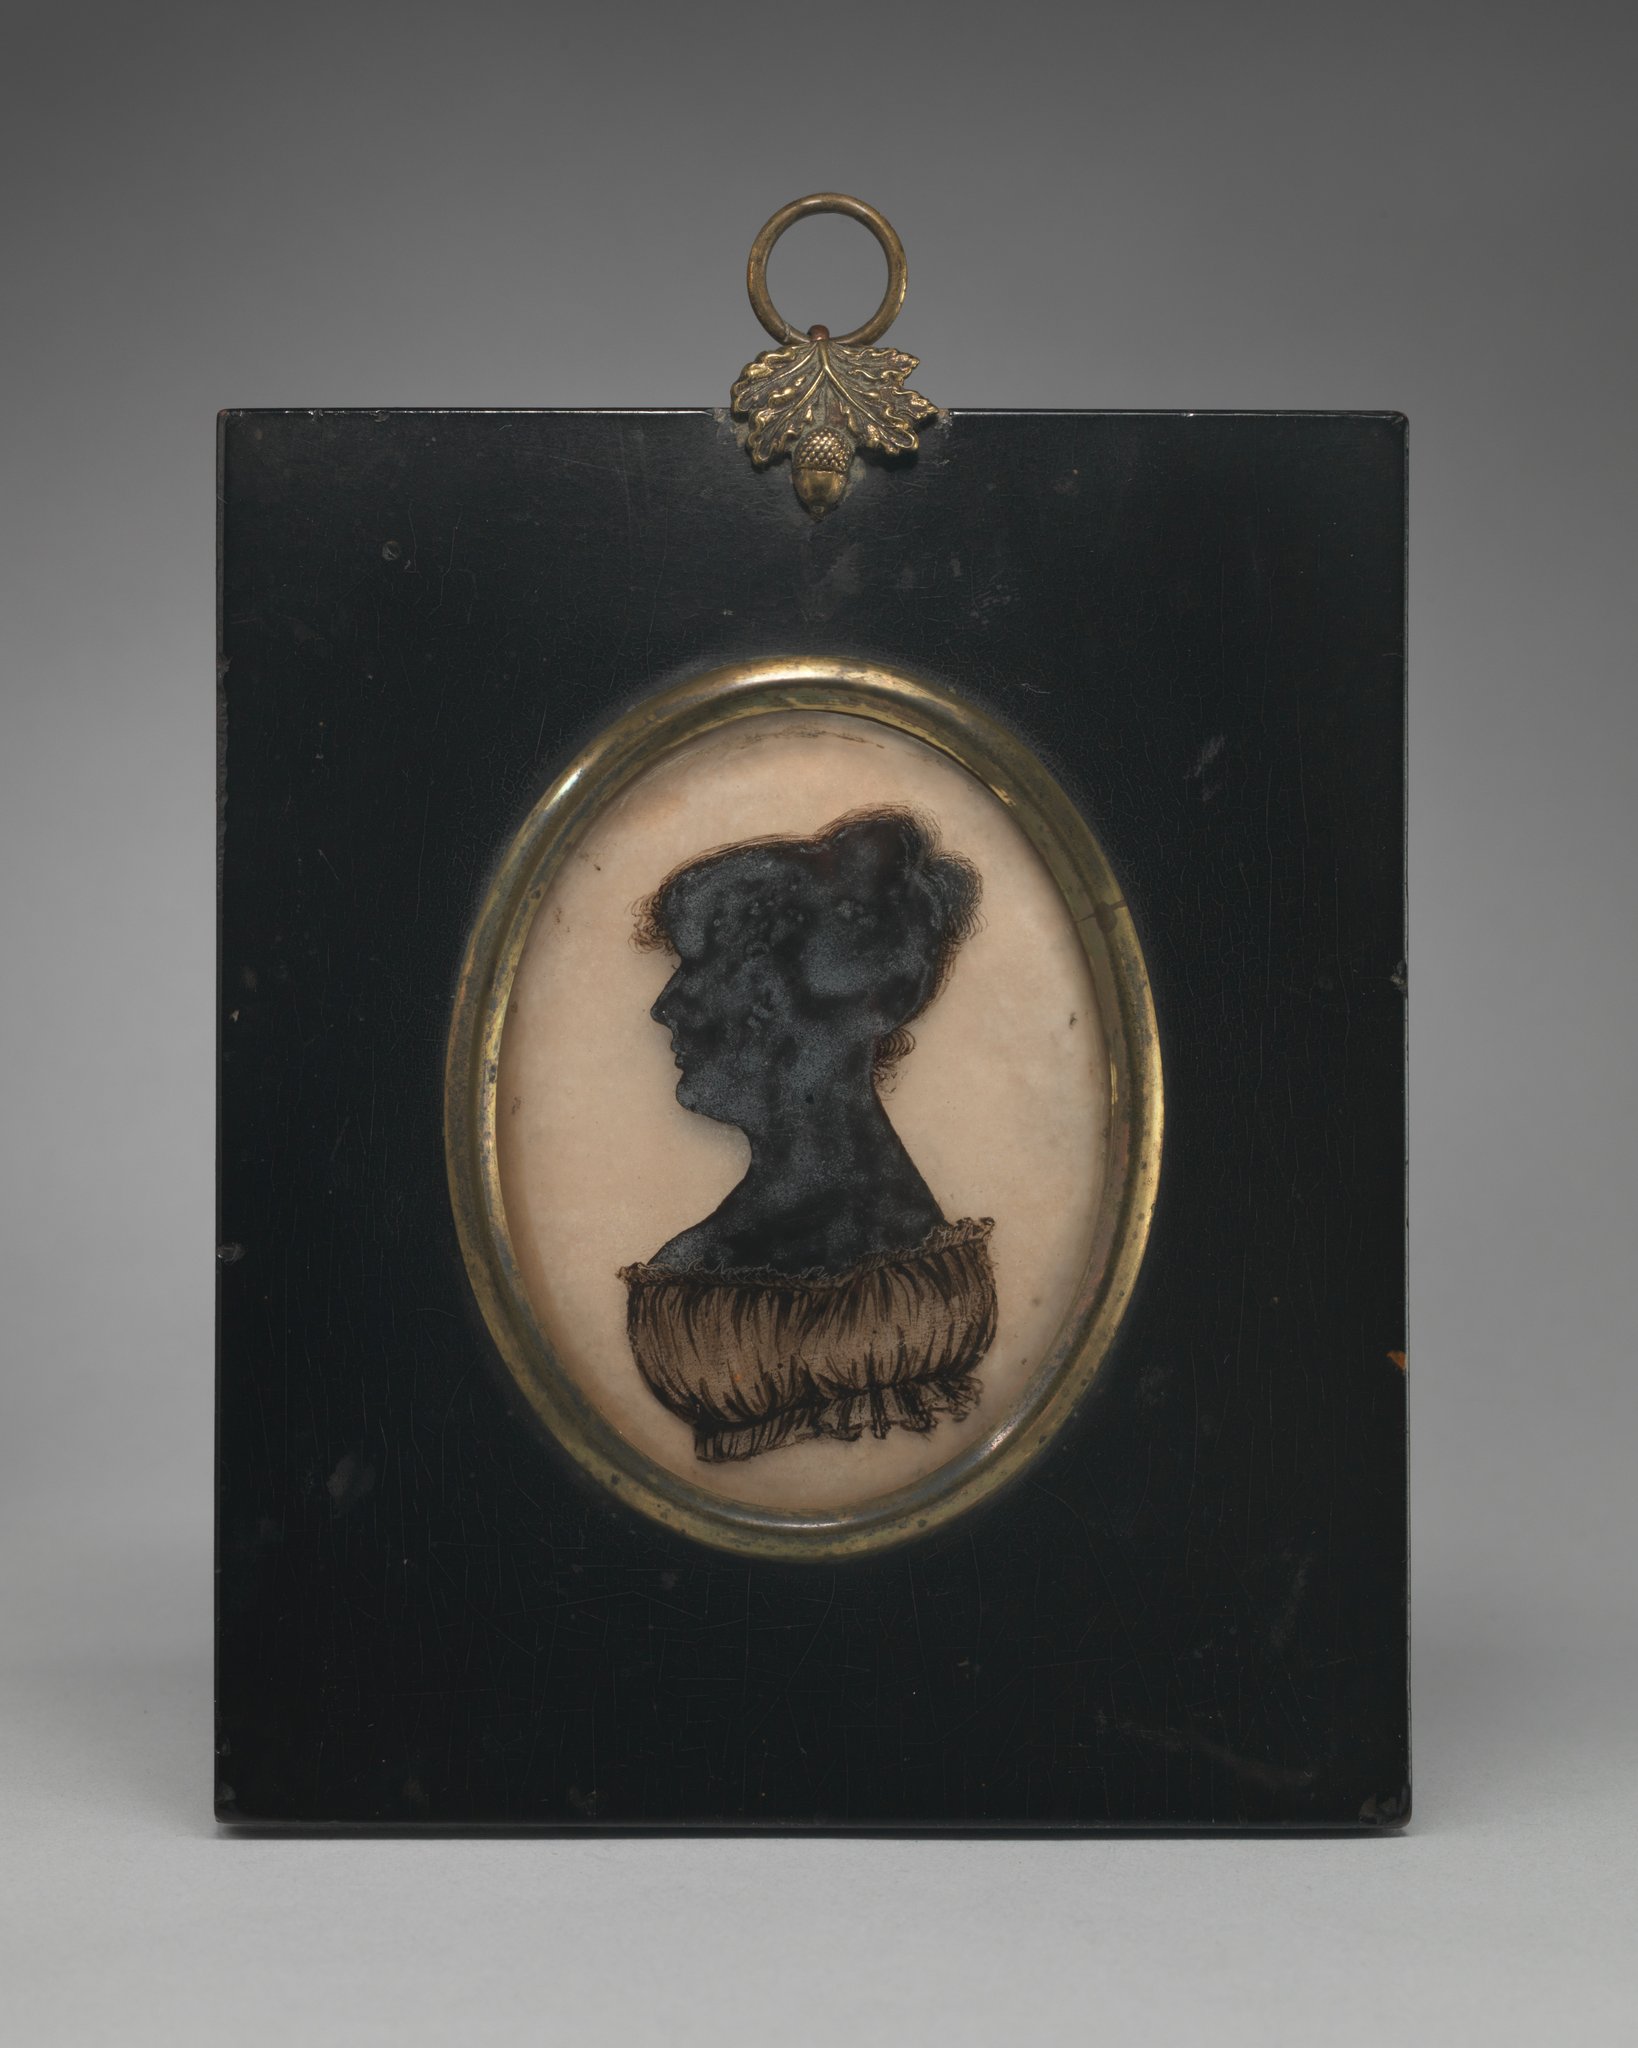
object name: plaque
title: Portrait of Charlotte White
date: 1801-1900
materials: glass, paper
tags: profiles,women